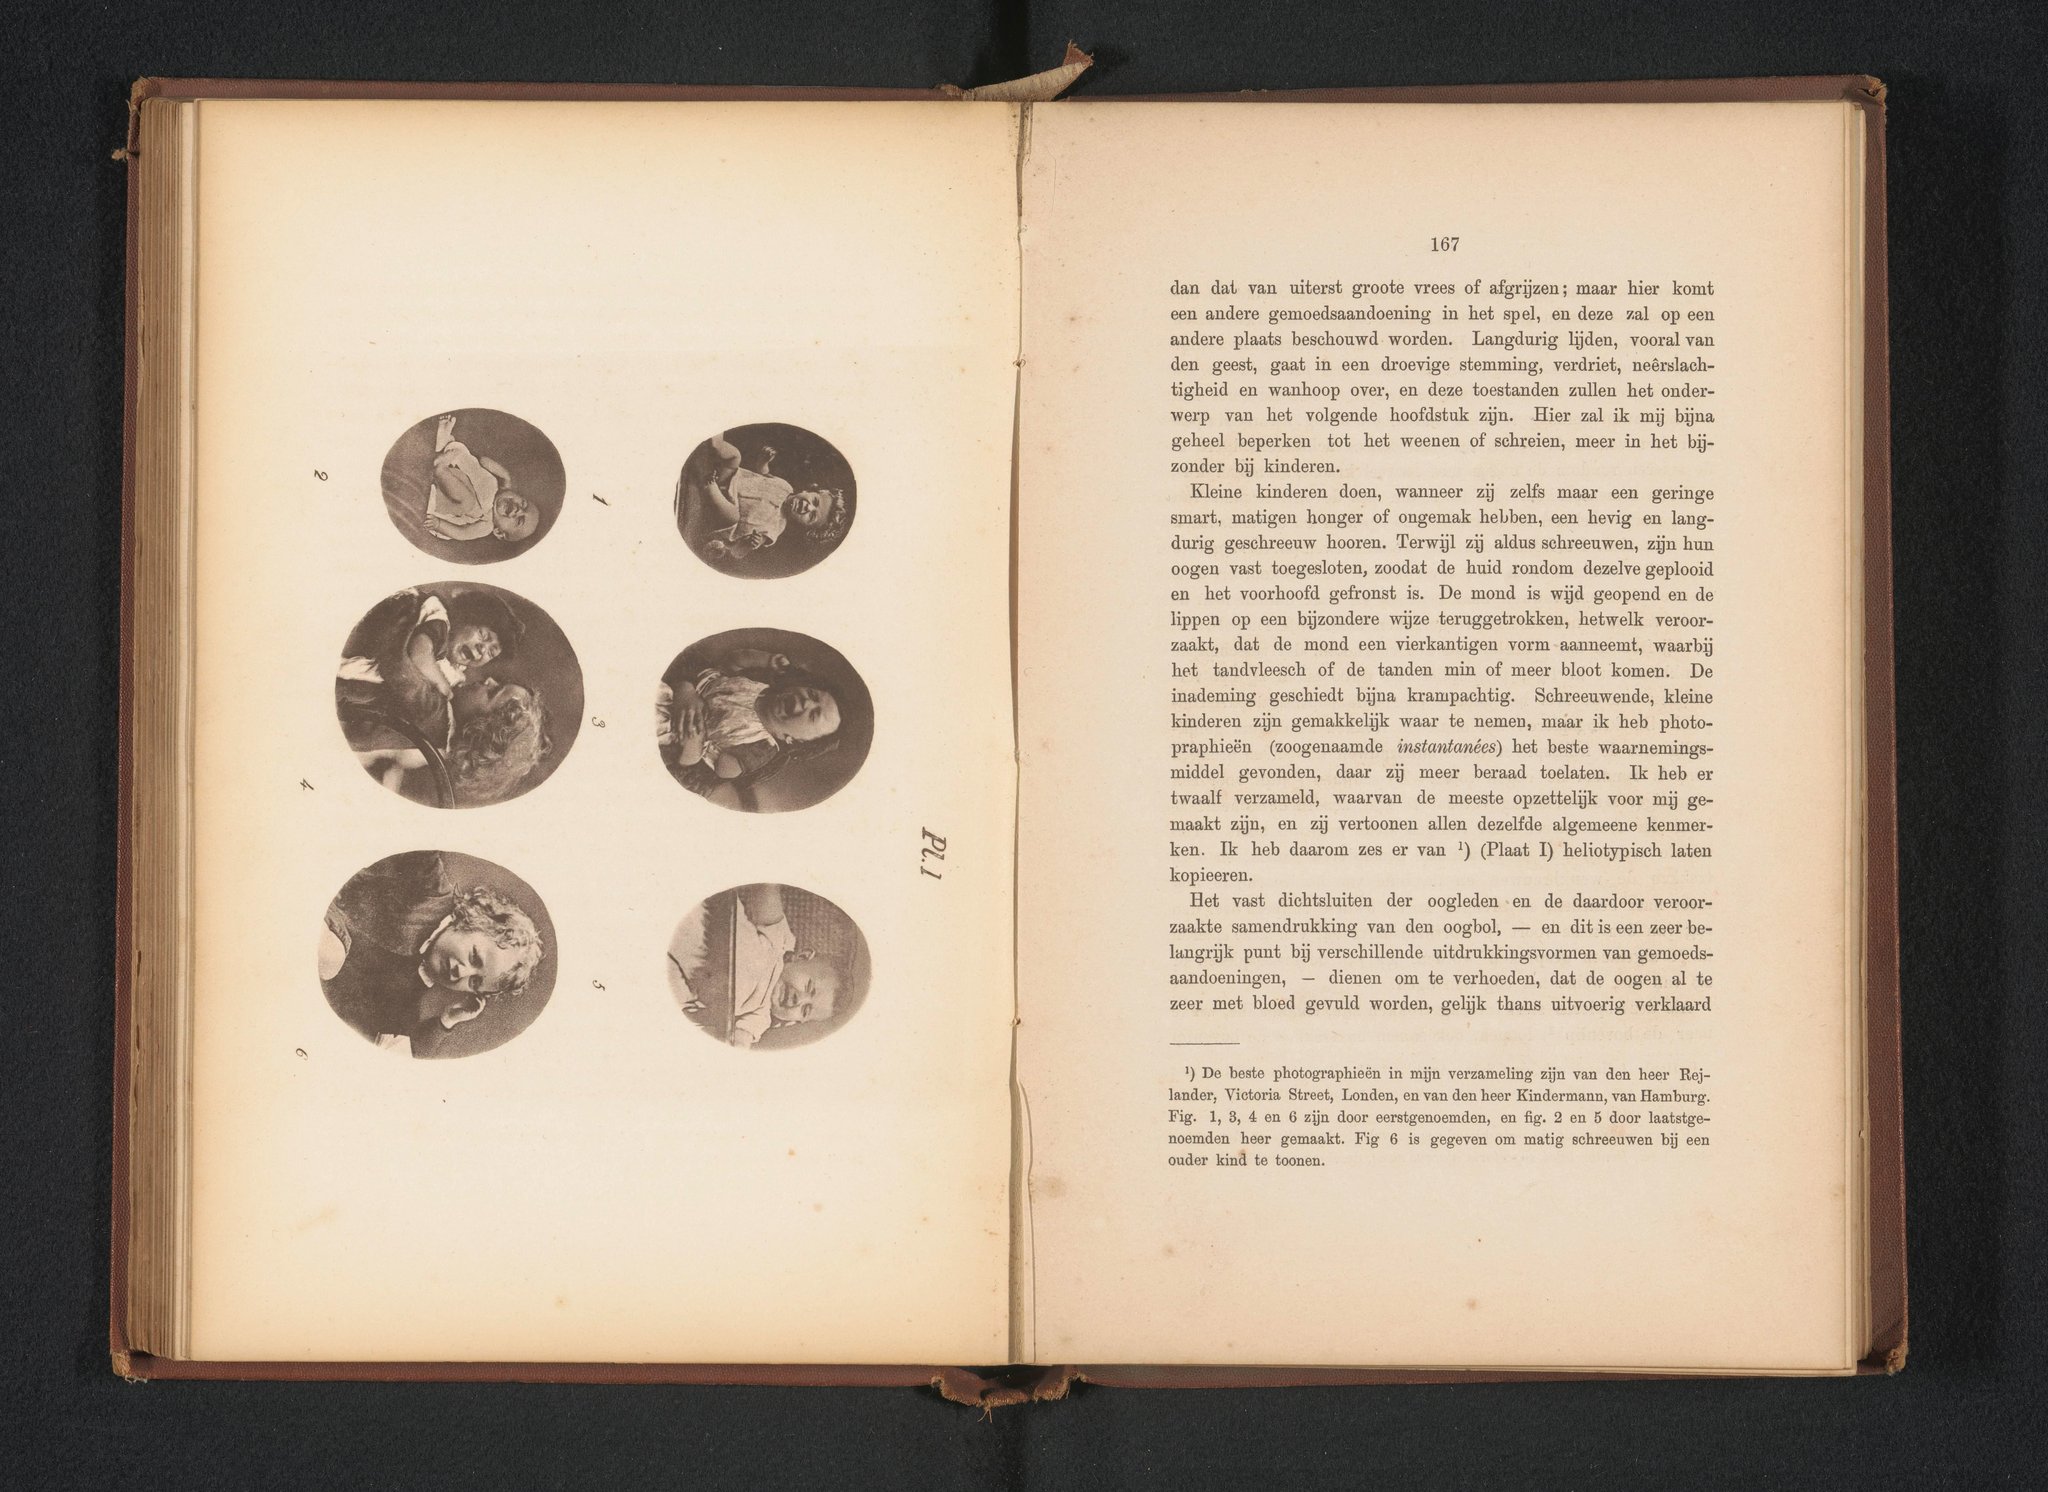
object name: photomechanical print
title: Overzicht van zes foto's ter illustratie van huilende baby's en kinderen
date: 1868-1873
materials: paper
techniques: photograph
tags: child, morphology of facial expression, crying, shouting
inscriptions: inscription: ‘Pl.1’